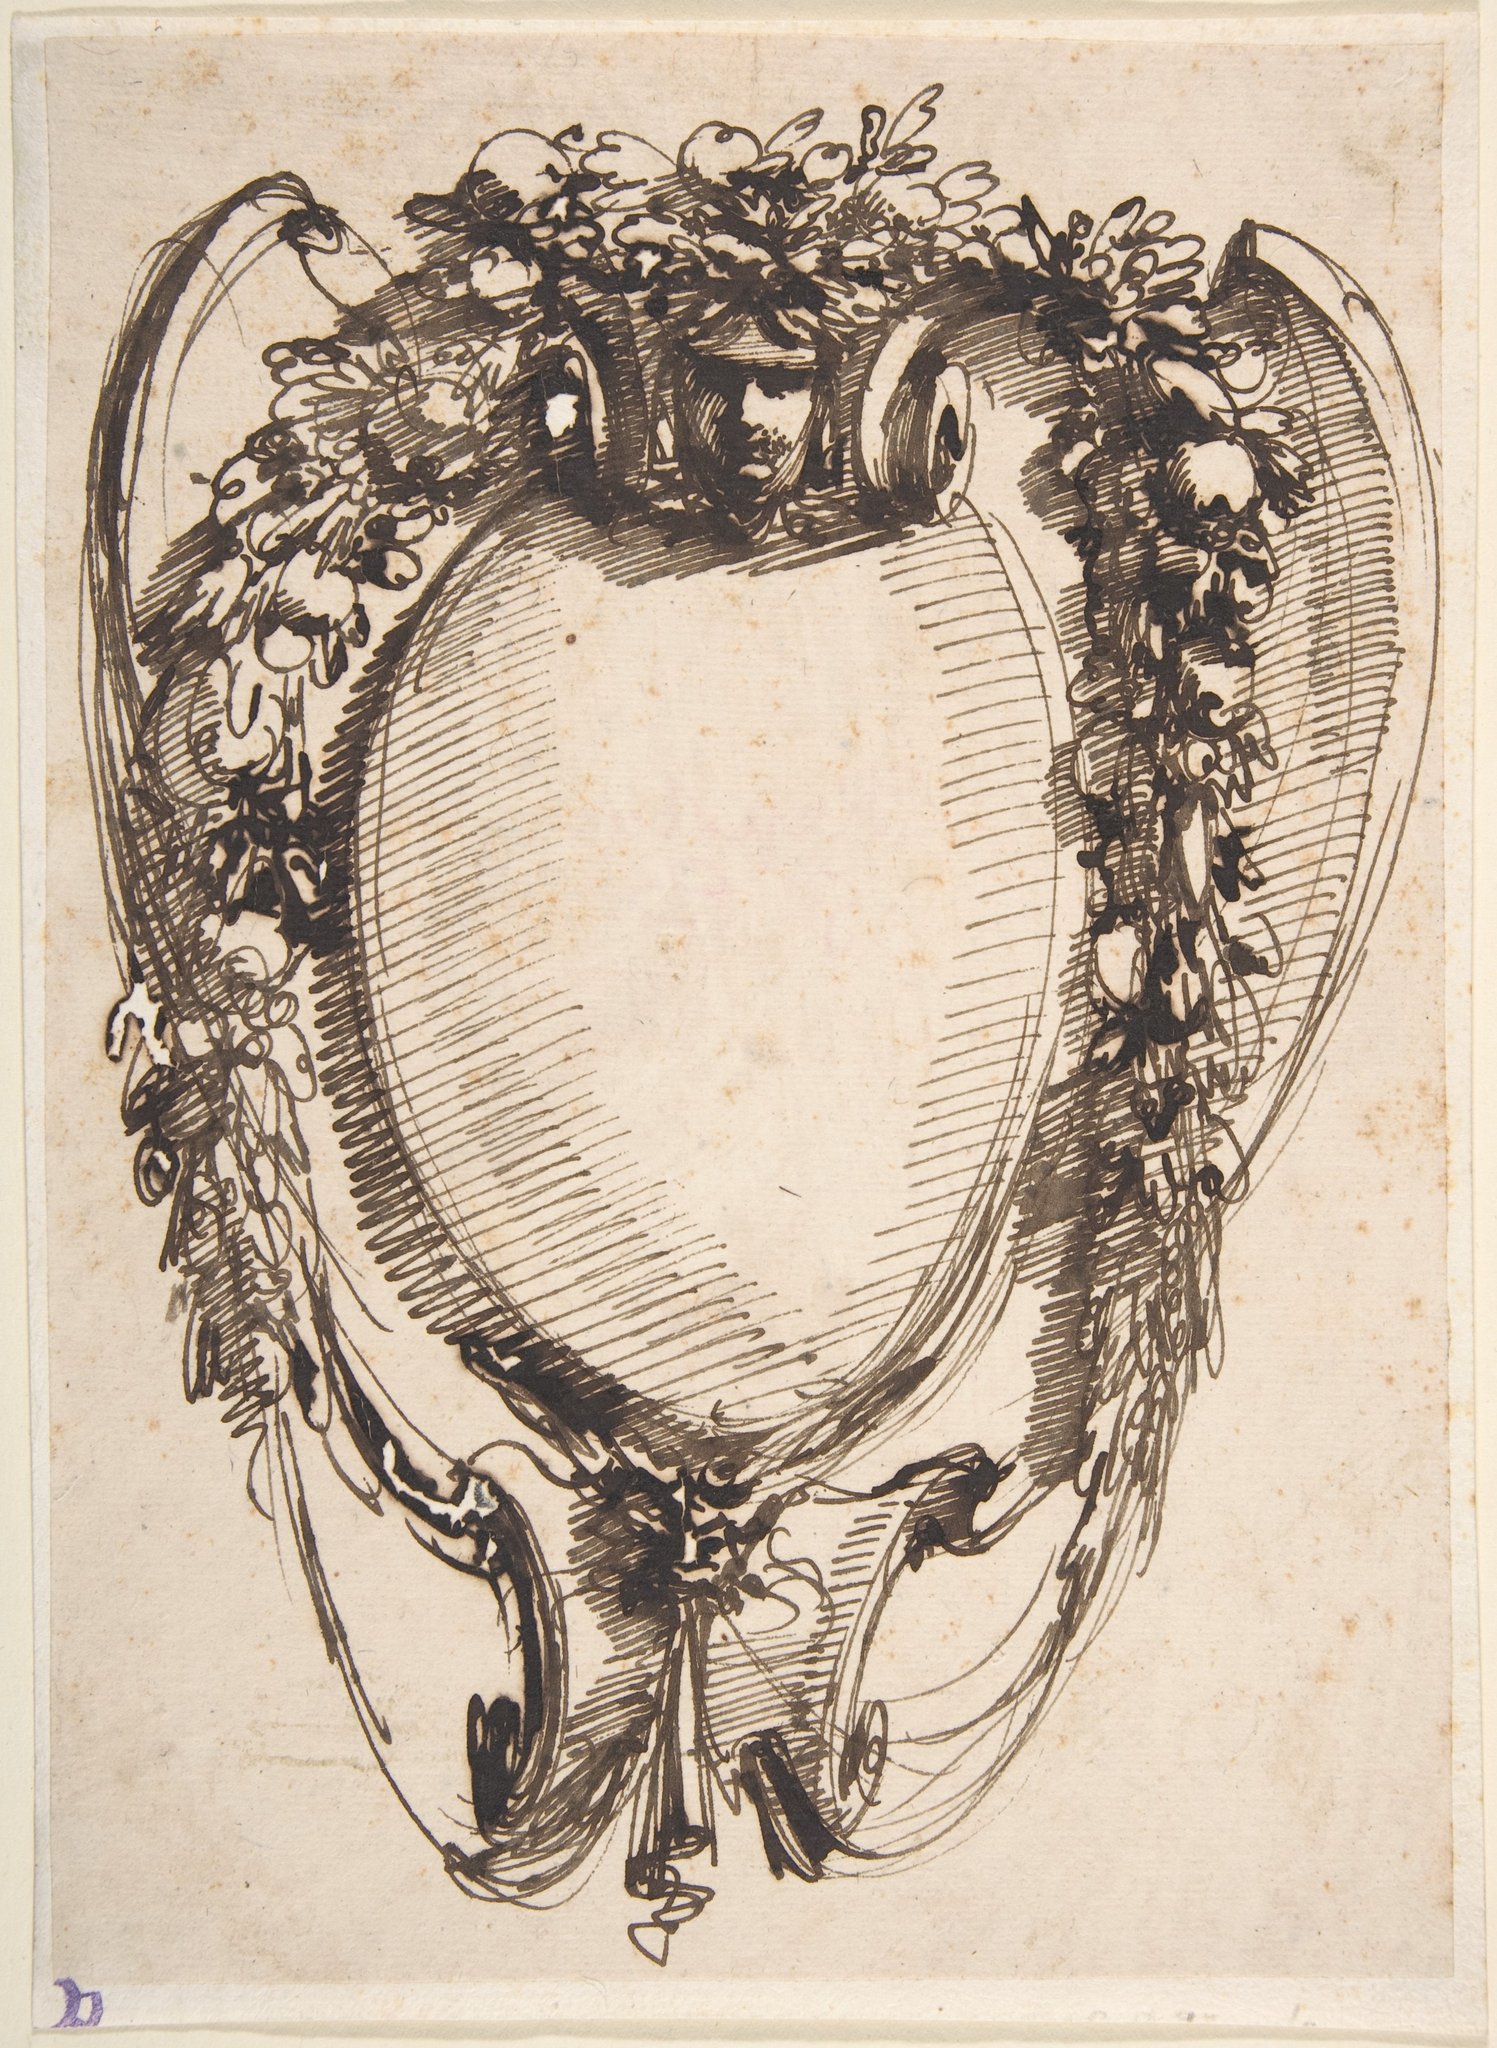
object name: drawing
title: Design for a Cartouche with Hanging Garlands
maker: carlo bianconi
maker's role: artist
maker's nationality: italian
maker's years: 1732-1802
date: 1752-1802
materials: ink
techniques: pen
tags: cartouches,garlands